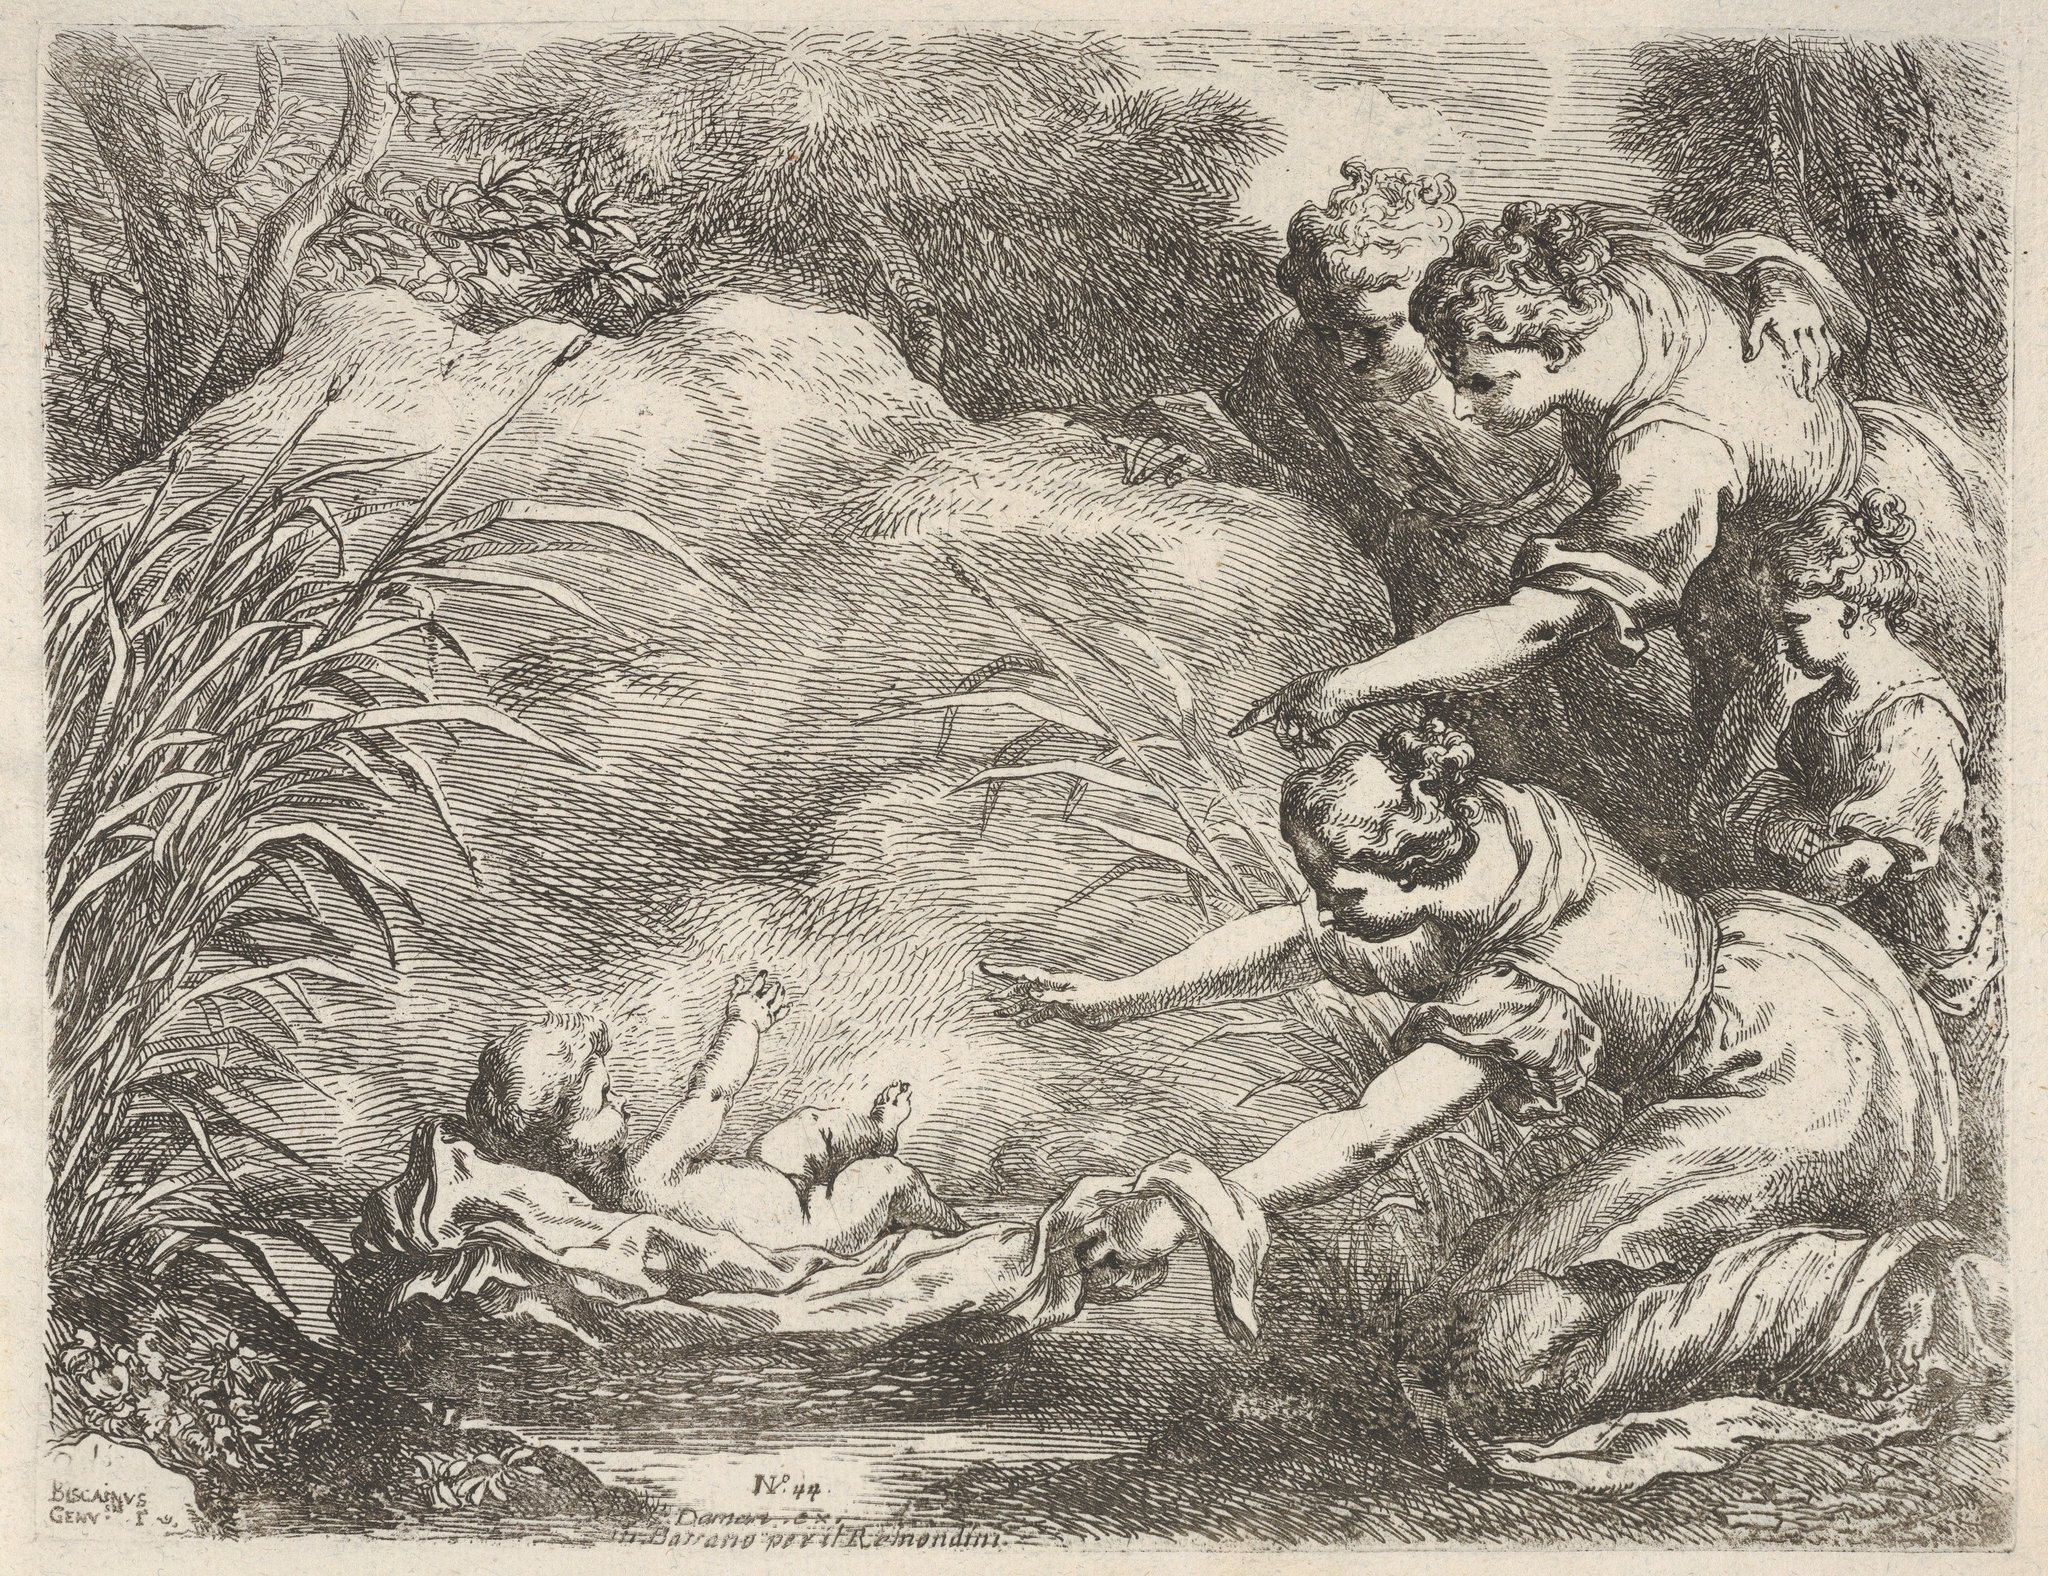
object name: print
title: The finding of Moses who is rescued from the Nile by the maidservants of Pharaoh's daughter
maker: bartolomeo biscaino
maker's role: artist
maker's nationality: italian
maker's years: 1632-1657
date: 1650-1657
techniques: etching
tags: girls,women,moses